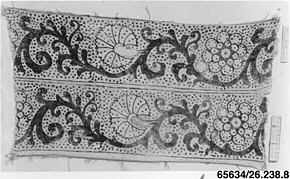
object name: fragment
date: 1701-1800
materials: linen